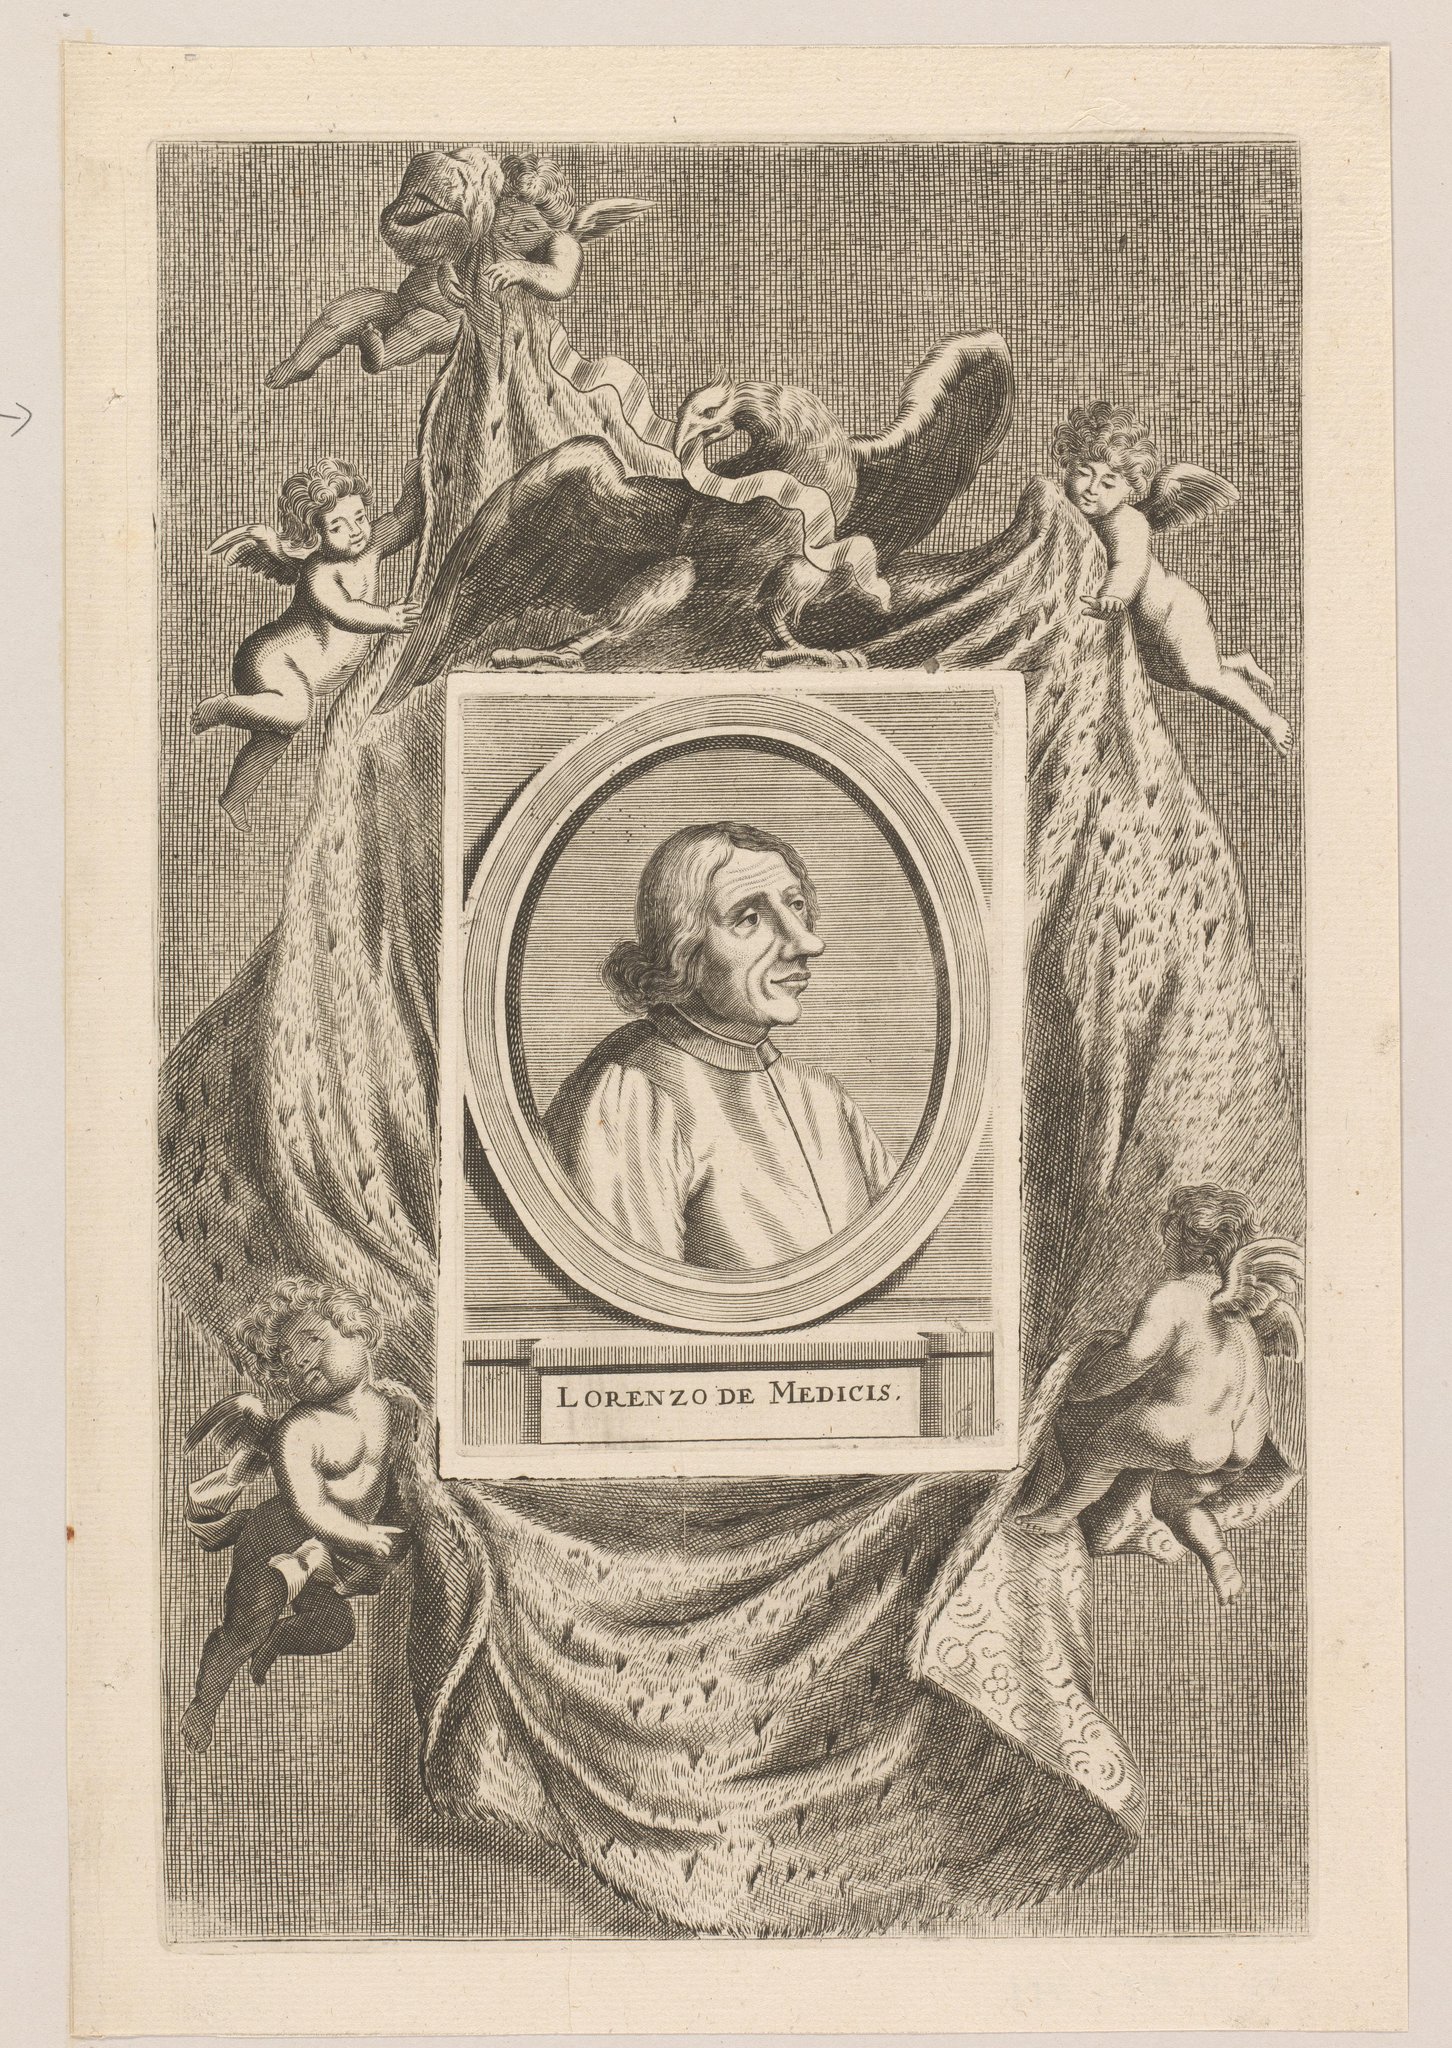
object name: book illustration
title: Portret van Lorenzo I de 'Medici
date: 1713-1714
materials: paper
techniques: engraving, etching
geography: low countries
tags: politician, historical persons, ruler, sovereign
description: Prent waarschijnlijk uit: Komen, Filips van. Las Memorias (...). Antwerpen: Hendrik en Cornelis Verdussen, 1713, dl. 2. Of uit de editie uit 1714.